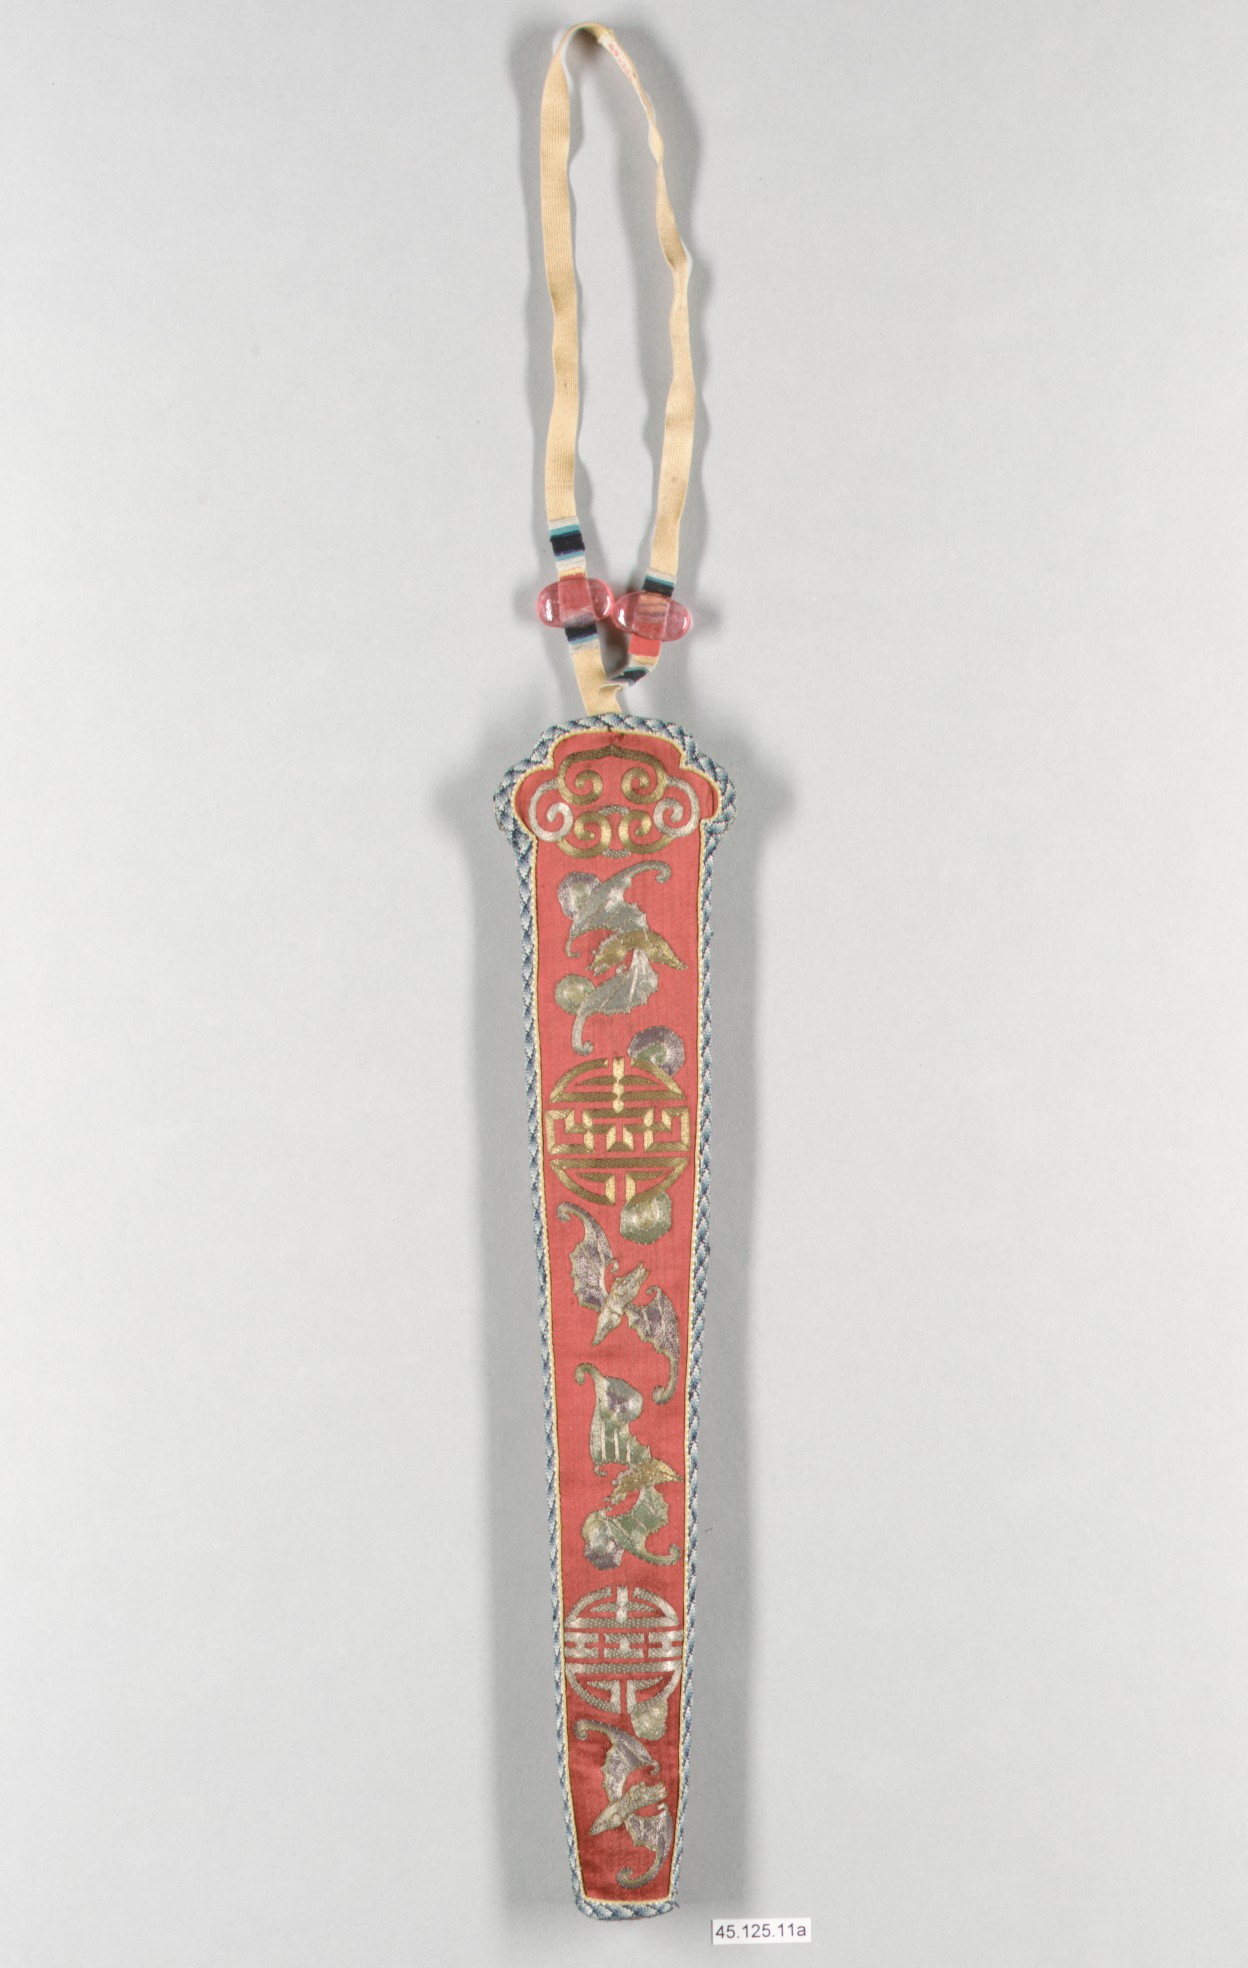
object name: girdle set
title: Girdle Set with Bats and the Character for Longevity (Shou)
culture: chinese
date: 1801-1900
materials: glass, metal thread, silk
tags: bats